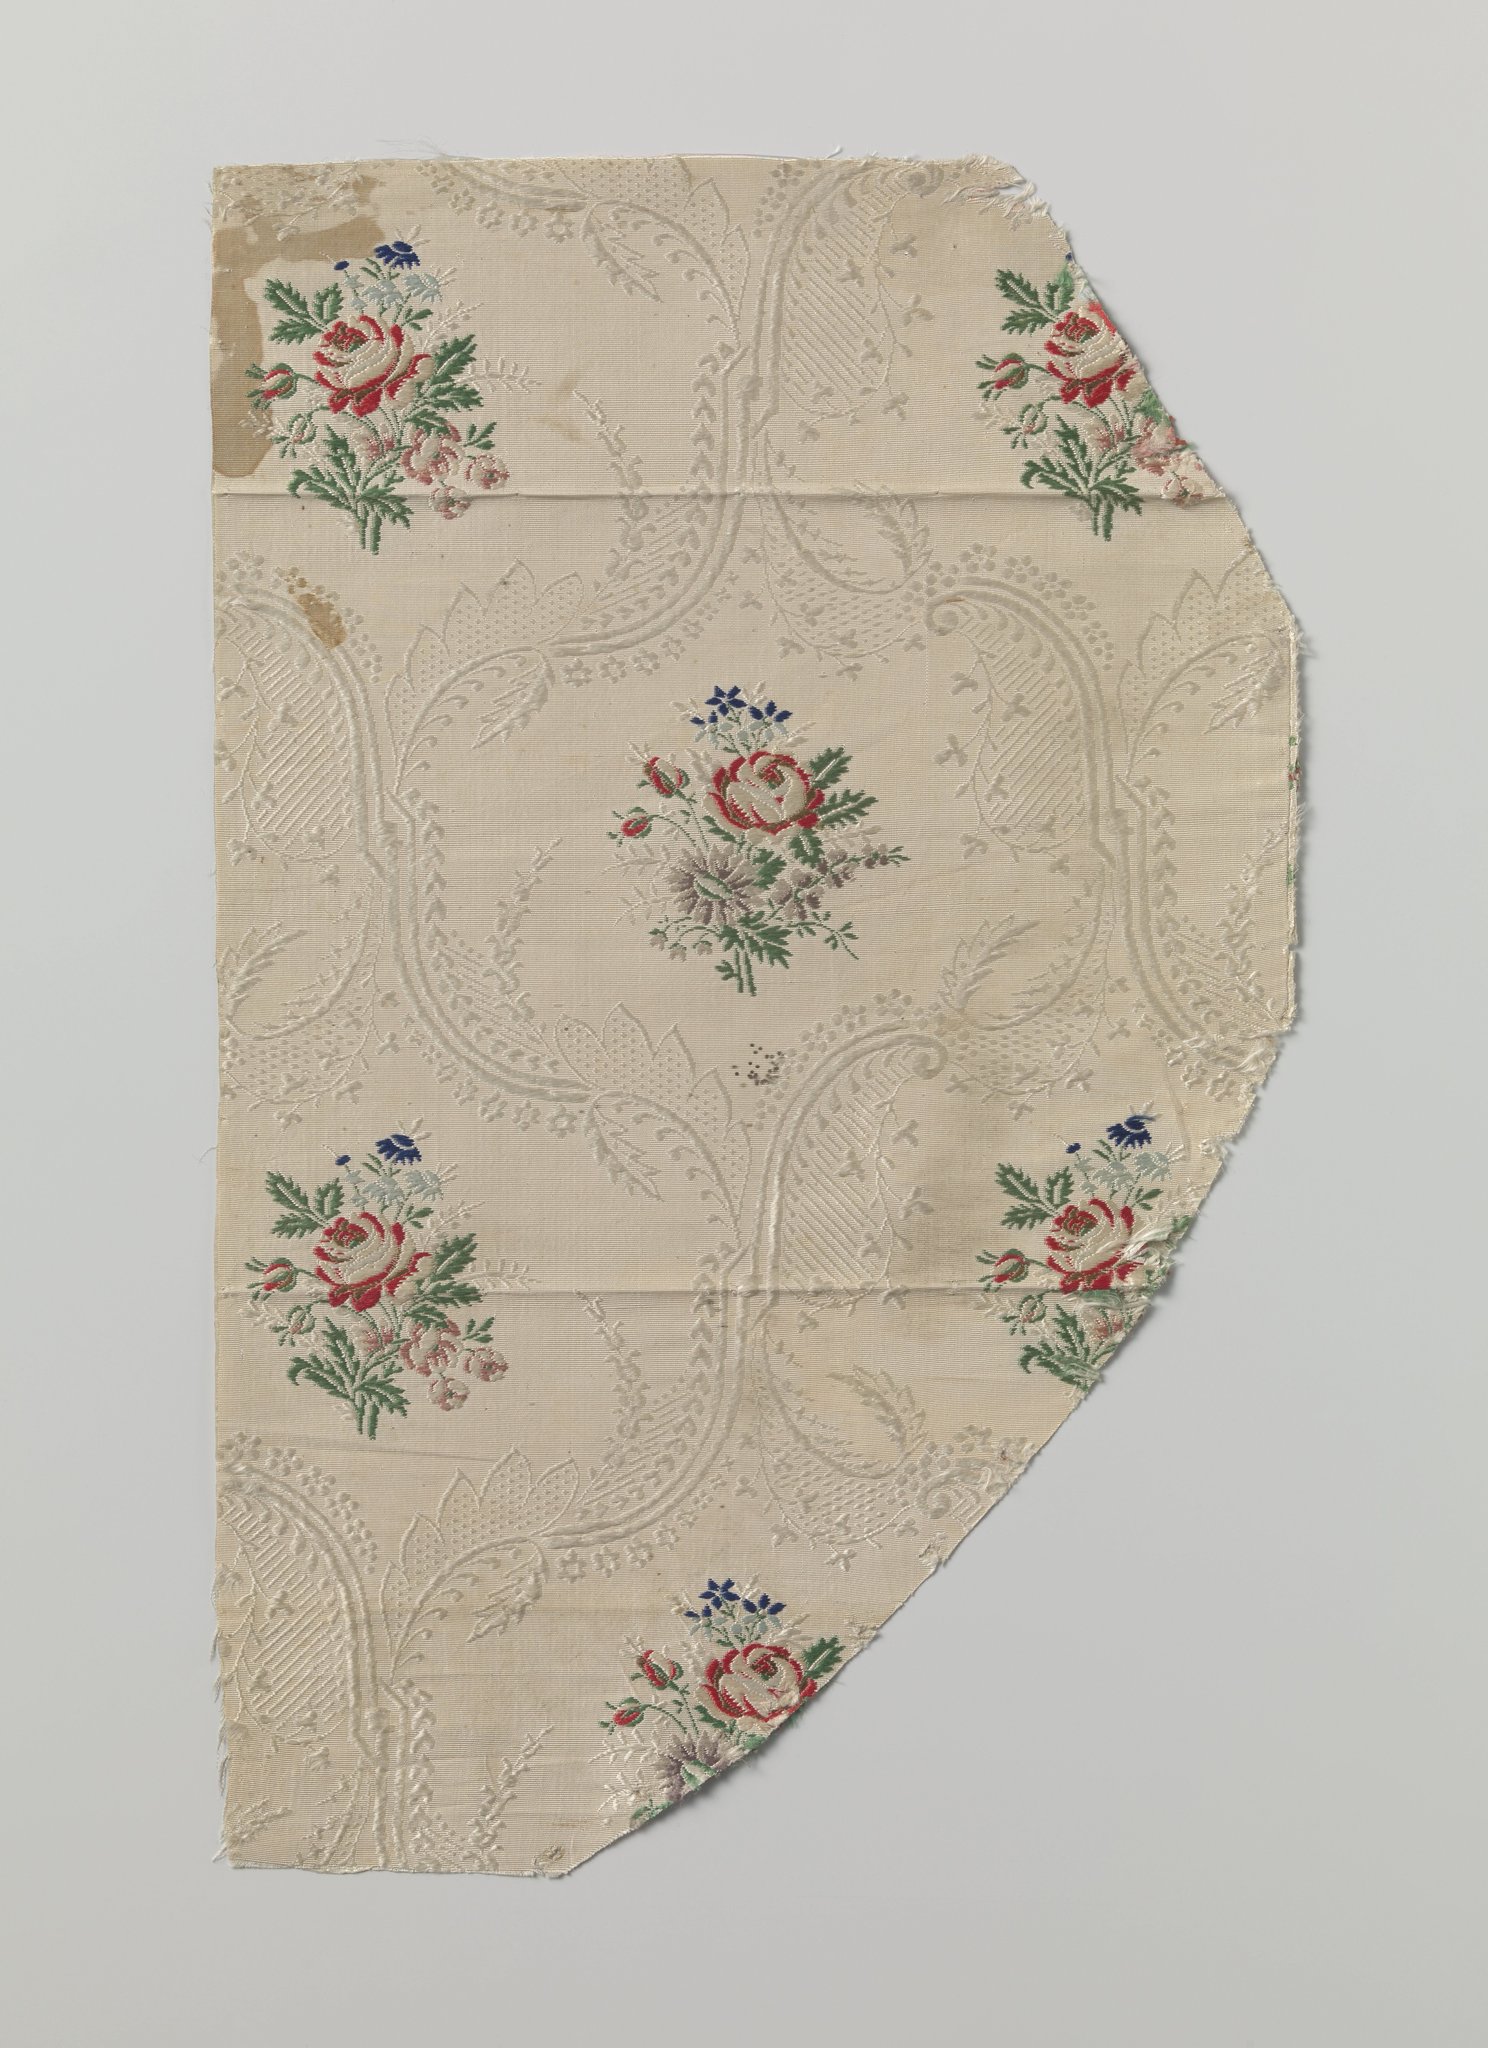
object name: fragment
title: Fragment veelkleurige gebrocheerde zijde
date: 1740-1760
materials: silk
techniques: brocade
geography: france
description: Een fragment zijdeweefsel. Een witte grond heeft een patroon van kantslingers die medaillons vormen waarbinnen veelkleurige bloemboeketten.